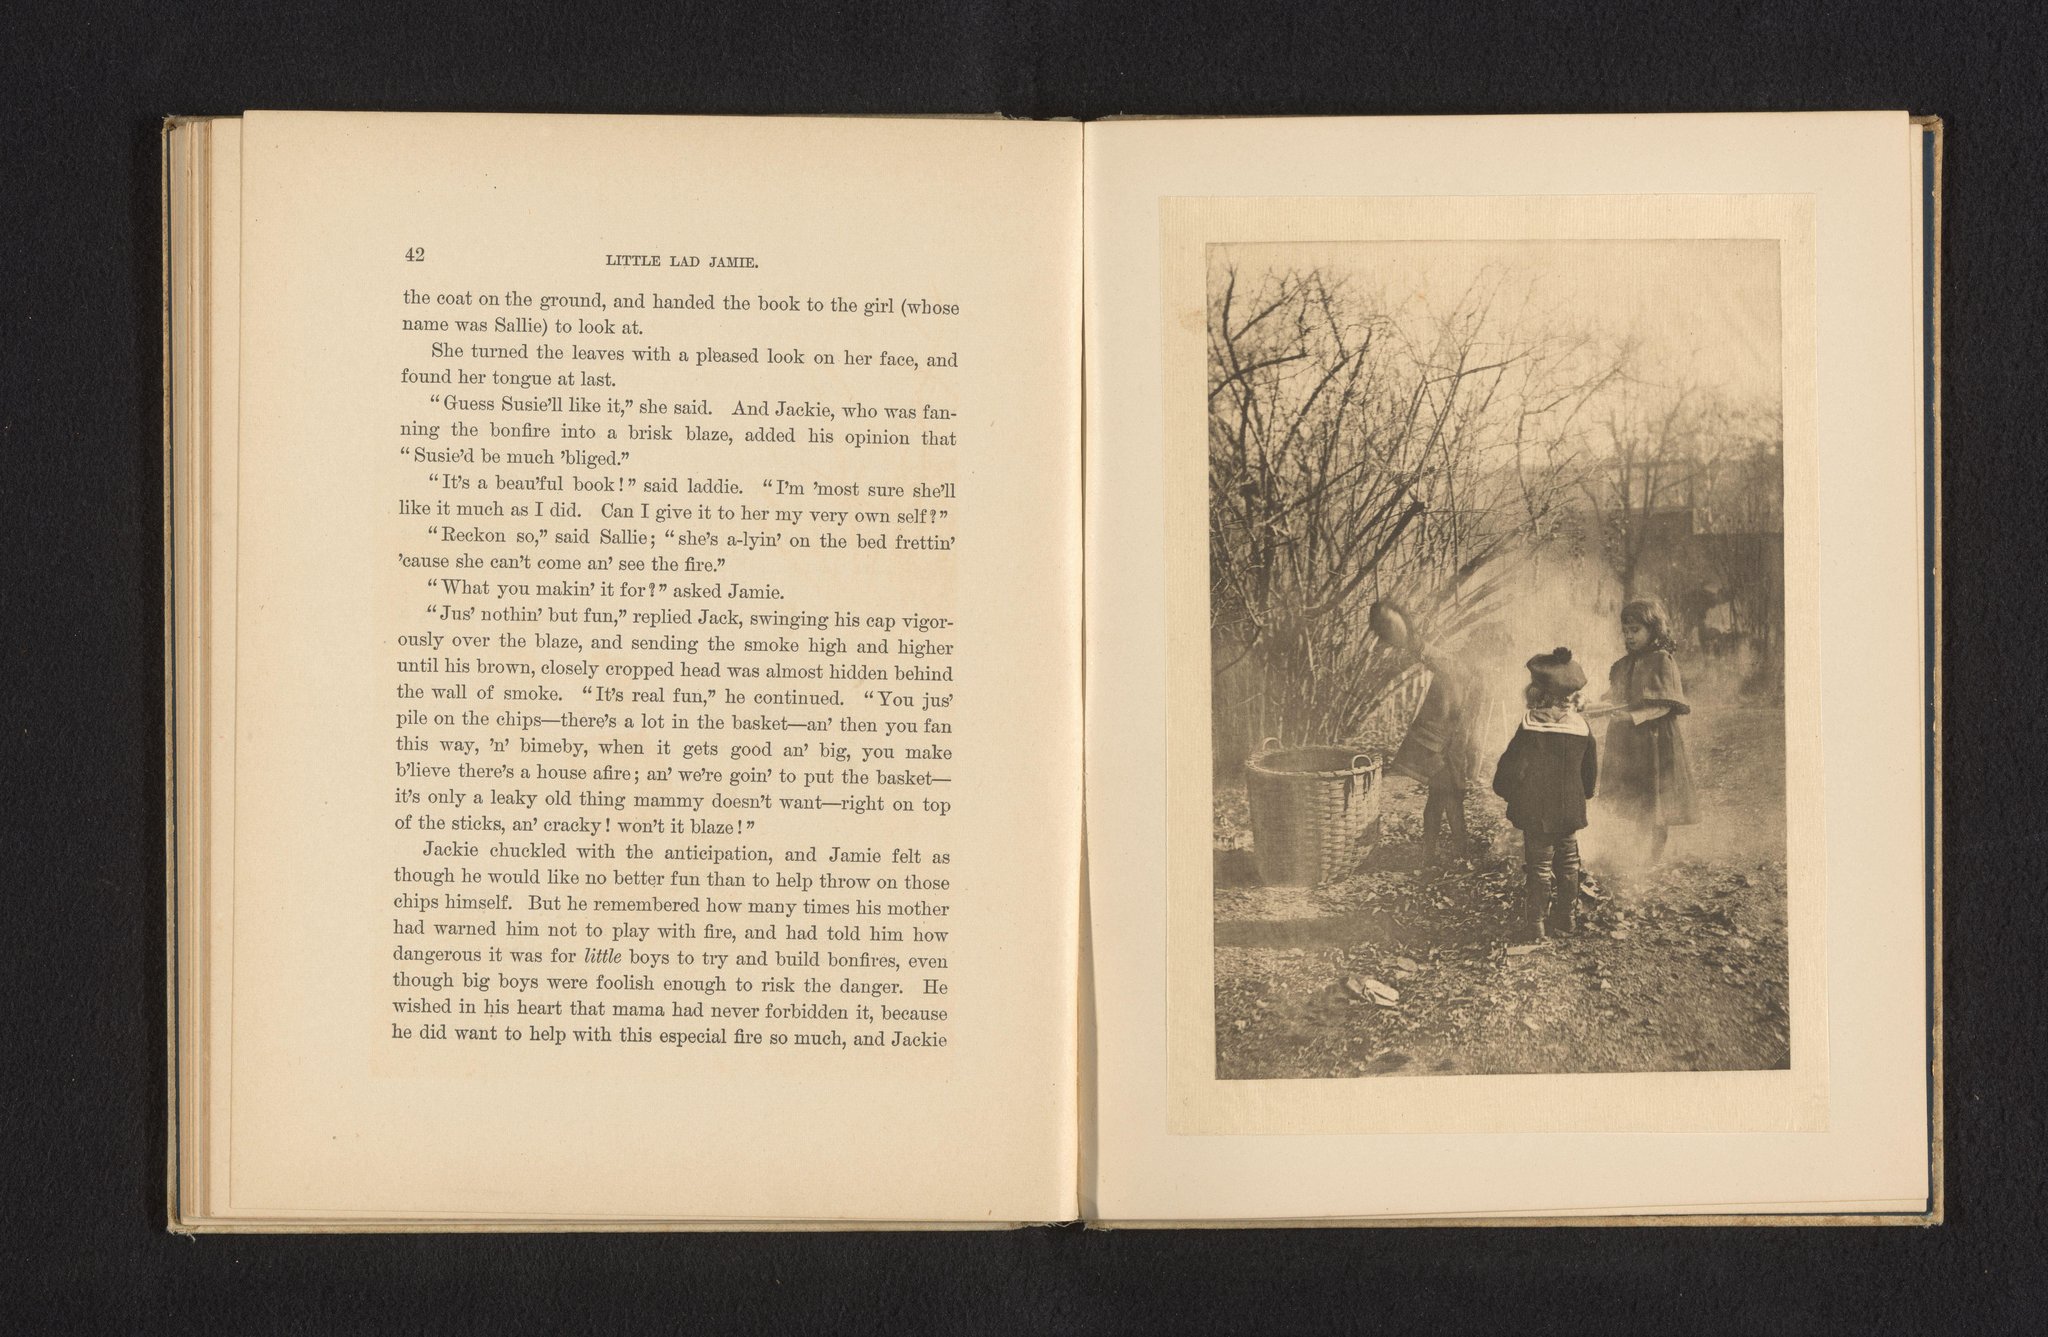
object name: page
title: Drie kinderen in een tuin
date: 1890-1895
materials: paper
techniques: photoaquatint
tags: garden, child between toddler and youth (of undetermined sex) (+ three persons)